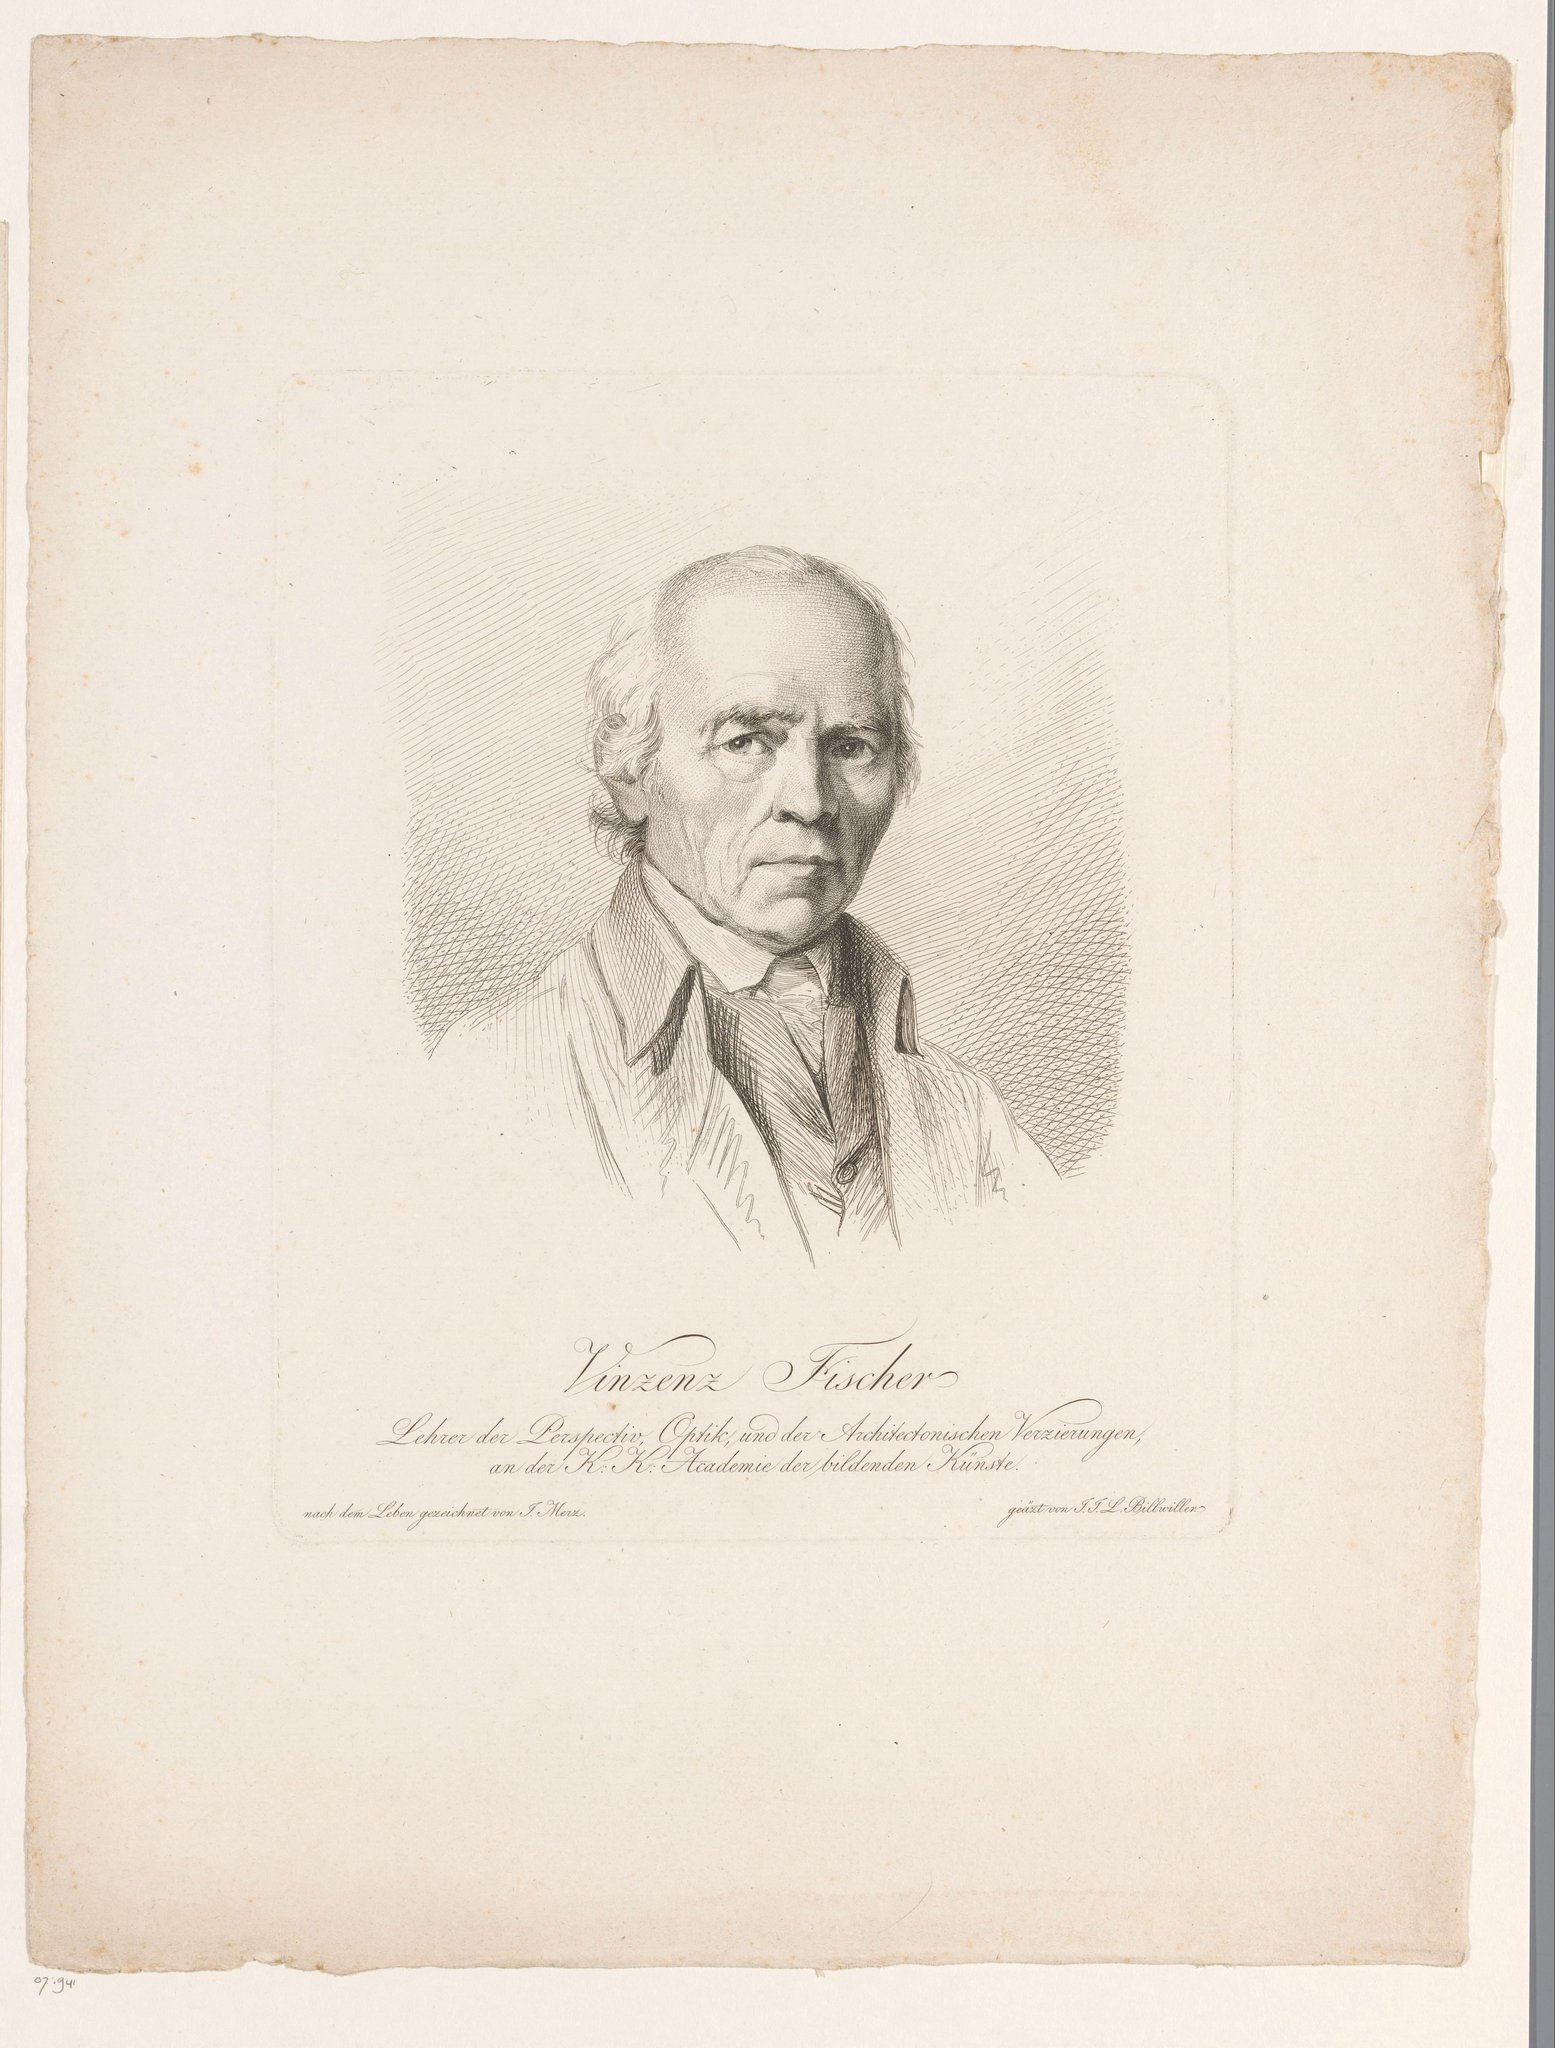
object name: print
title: Portret van Vinzenz Fischer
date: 1805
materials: paper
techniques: etching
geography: vienna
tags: vienna, painter, portrait, self-portrait of artist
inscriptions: collector's mark: Lugt 2228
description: De prent maakt onderdeel uit van een serie van zes portretten van docenten werkzaam aan de Akademie der bildenden Künste te Wenen.